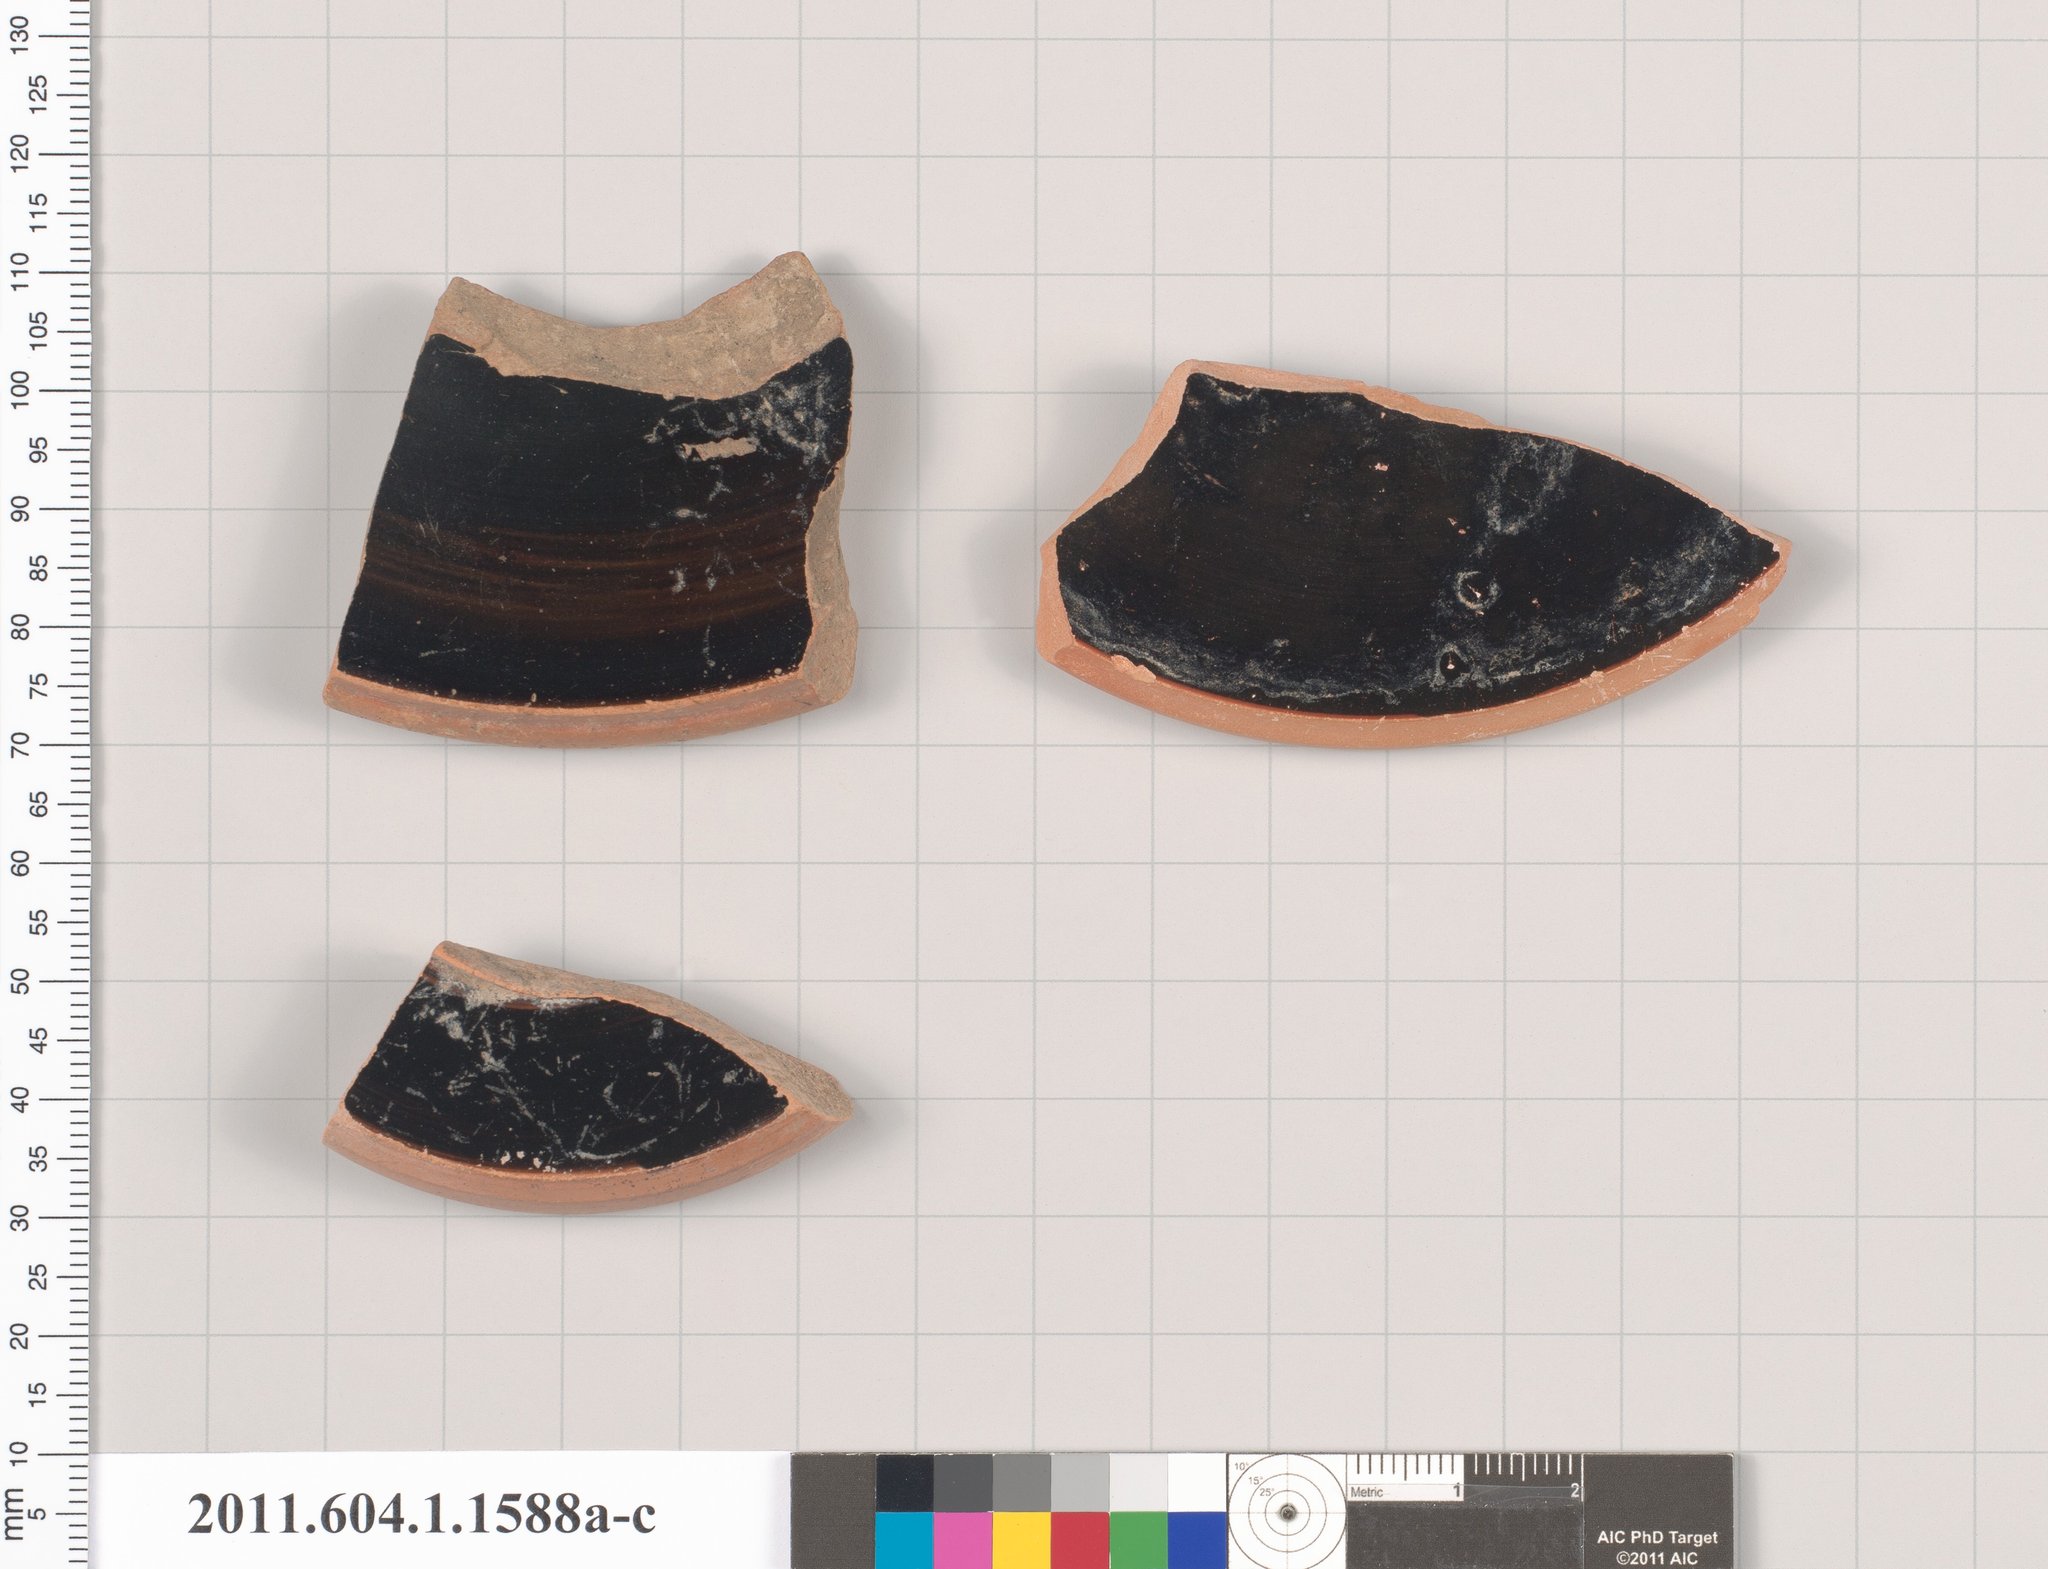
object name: kylix fragment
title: Terracotta fragments of kylikes (drinking cups)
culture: greek, attic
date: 500-401 BCE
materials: terracotta